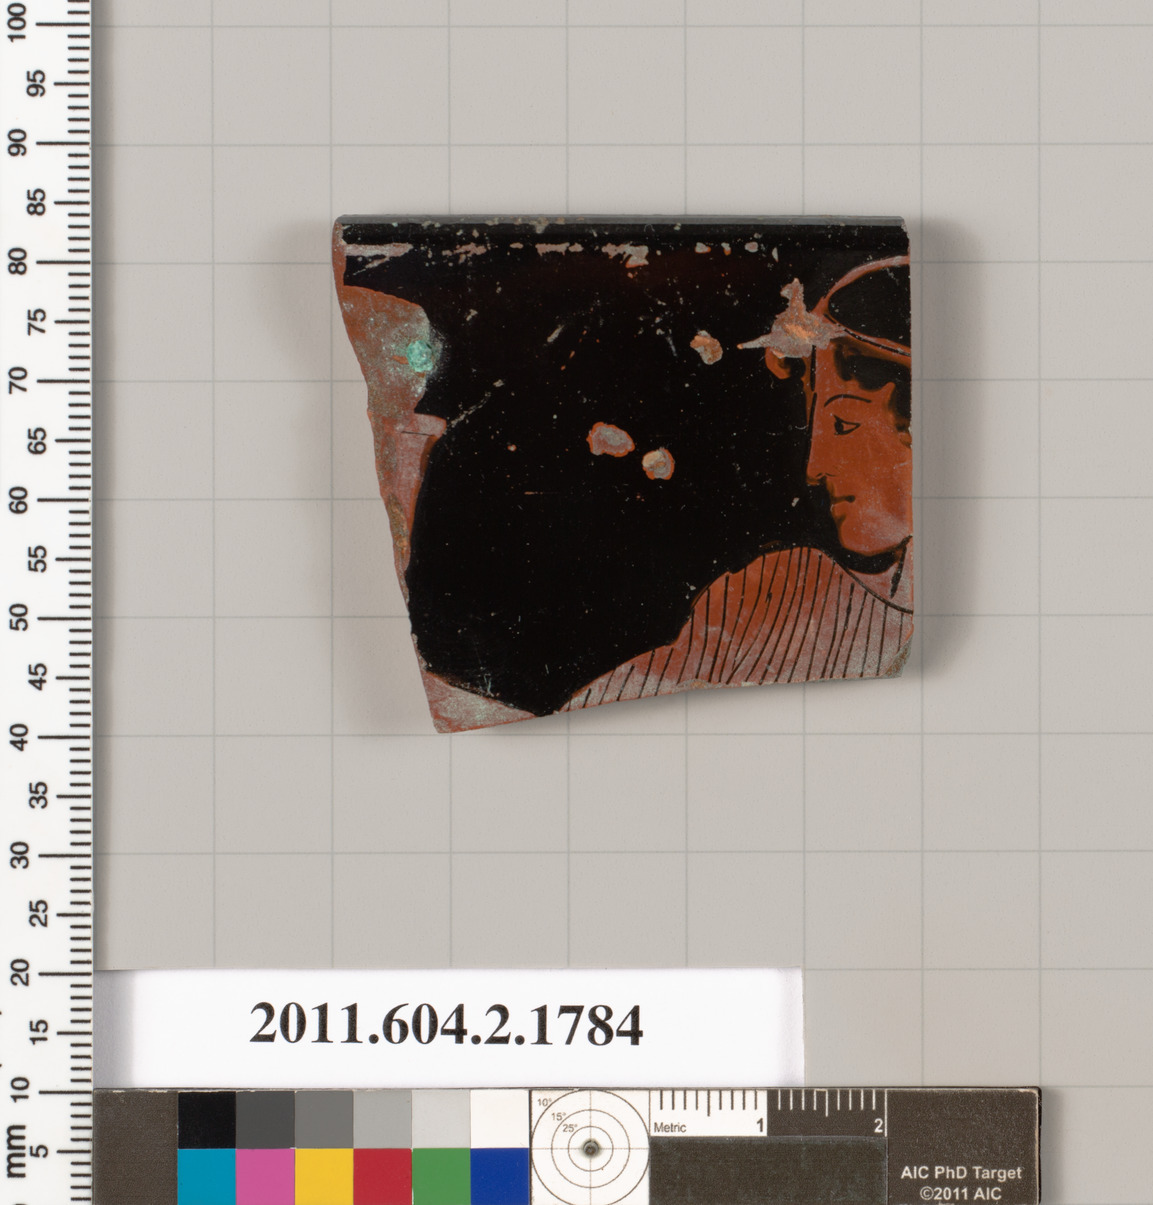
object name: skyphos fragment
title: Terracotta rim fragment of a skyphos (deep drinking cup)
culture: greek, attic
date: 460-440 BCE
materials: terracotta